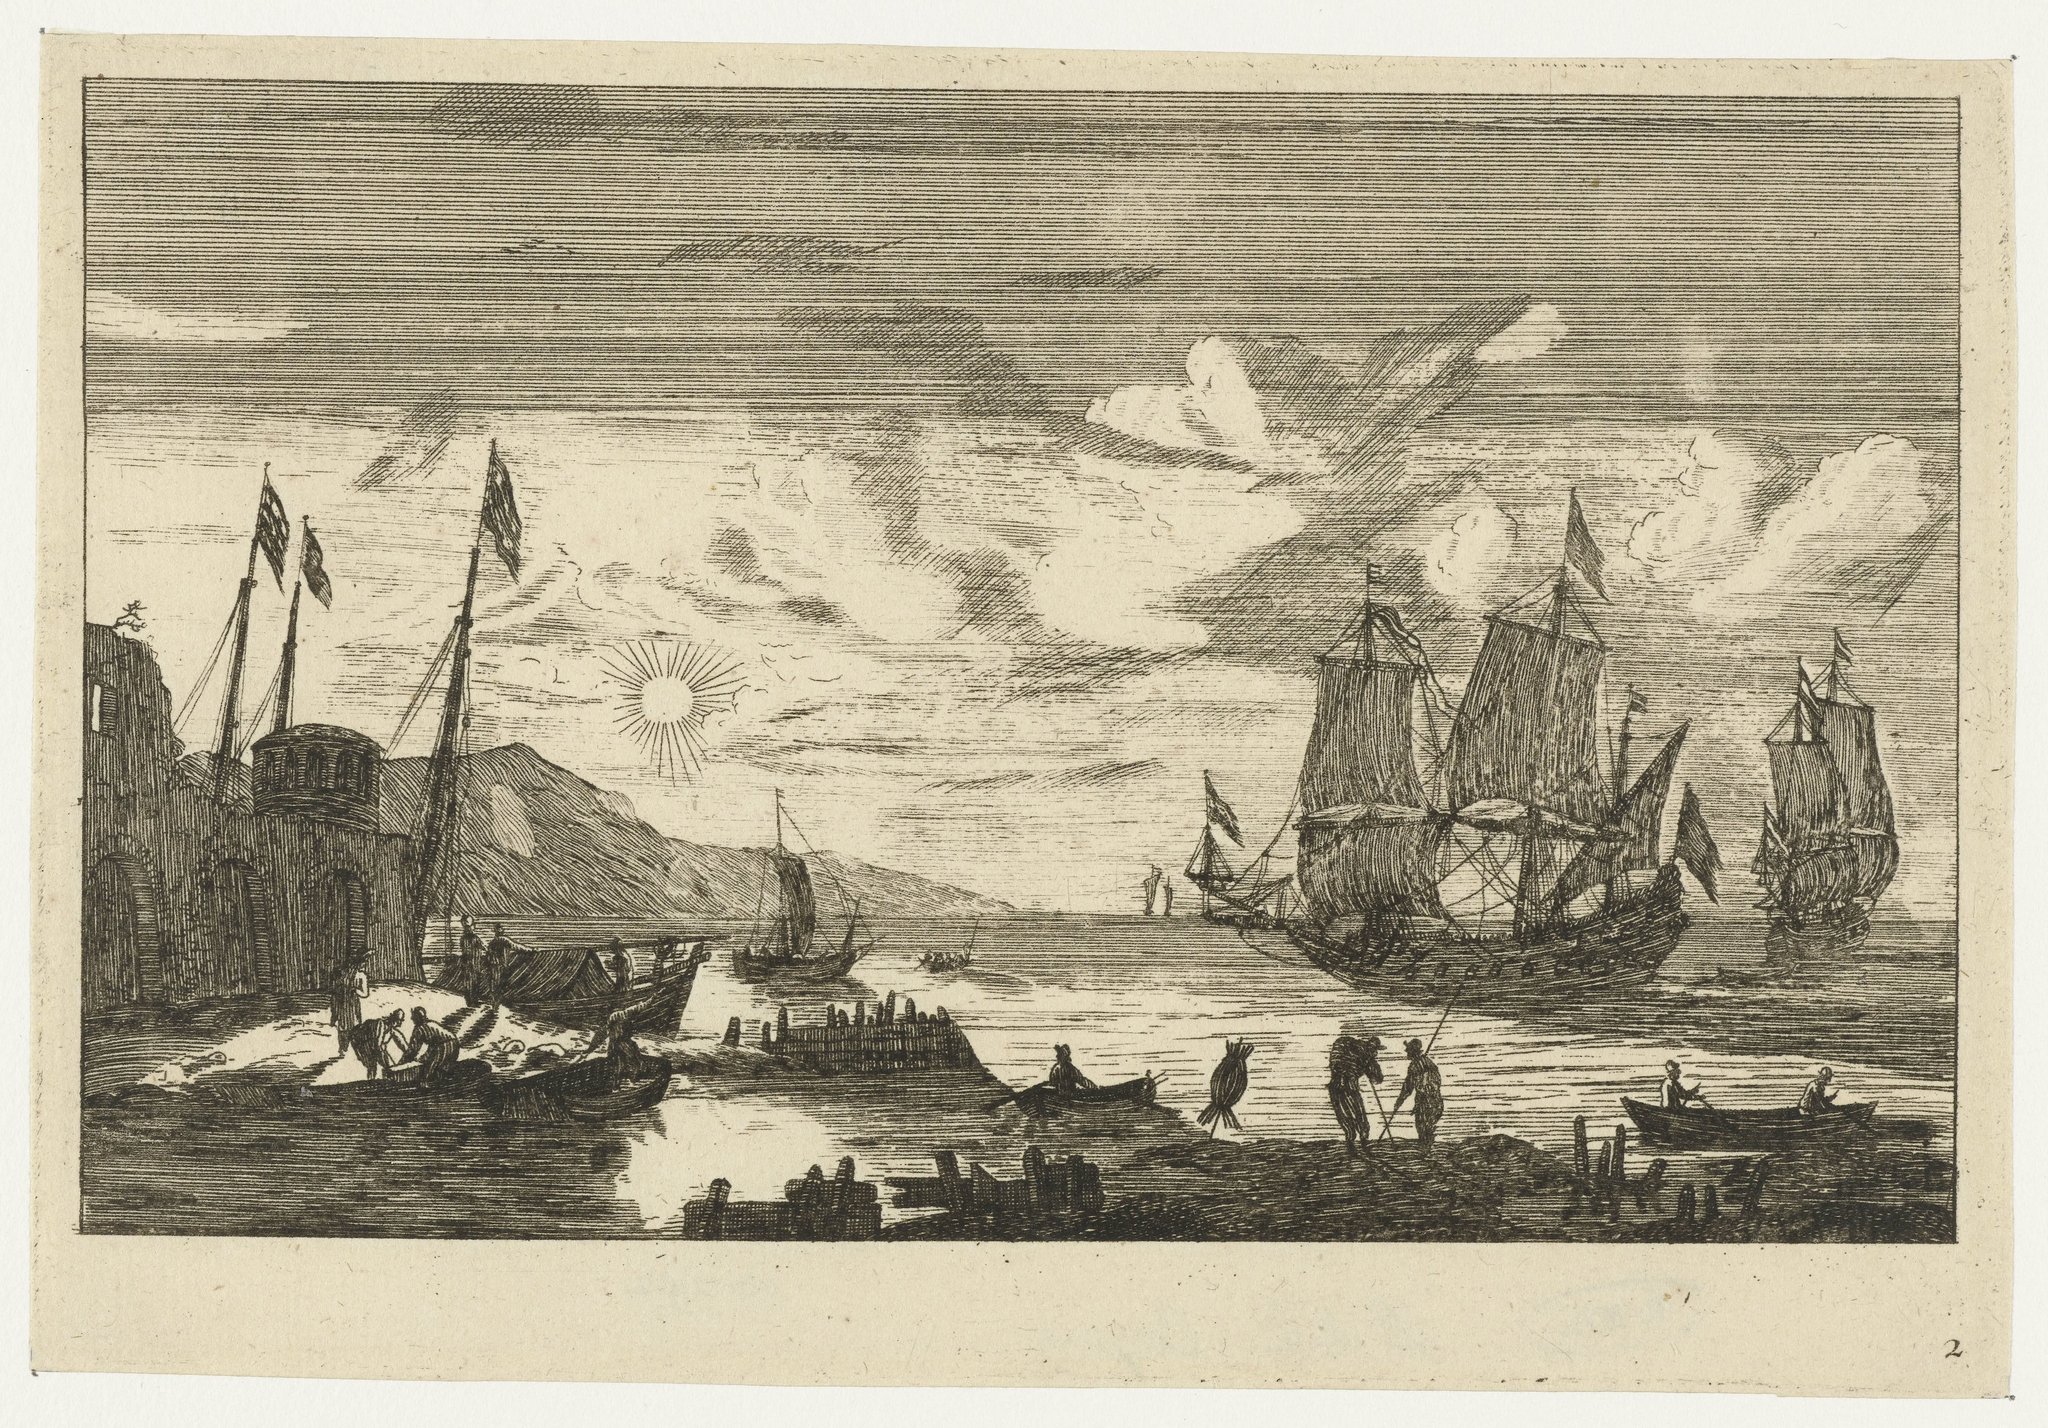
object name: print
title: Haven met twee grote zeilschepen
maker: Anonymous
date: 1656-1714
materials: paper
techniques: etching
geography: netherlands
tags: harbour, gulf, bay, sailing-ship, sailing-boat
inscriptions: collector's mark: Lugt 2228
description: Kopie in spiegelbeeld. Havenscène met twee grote Nederlandse zeilschepen bij een ondergaande zon.